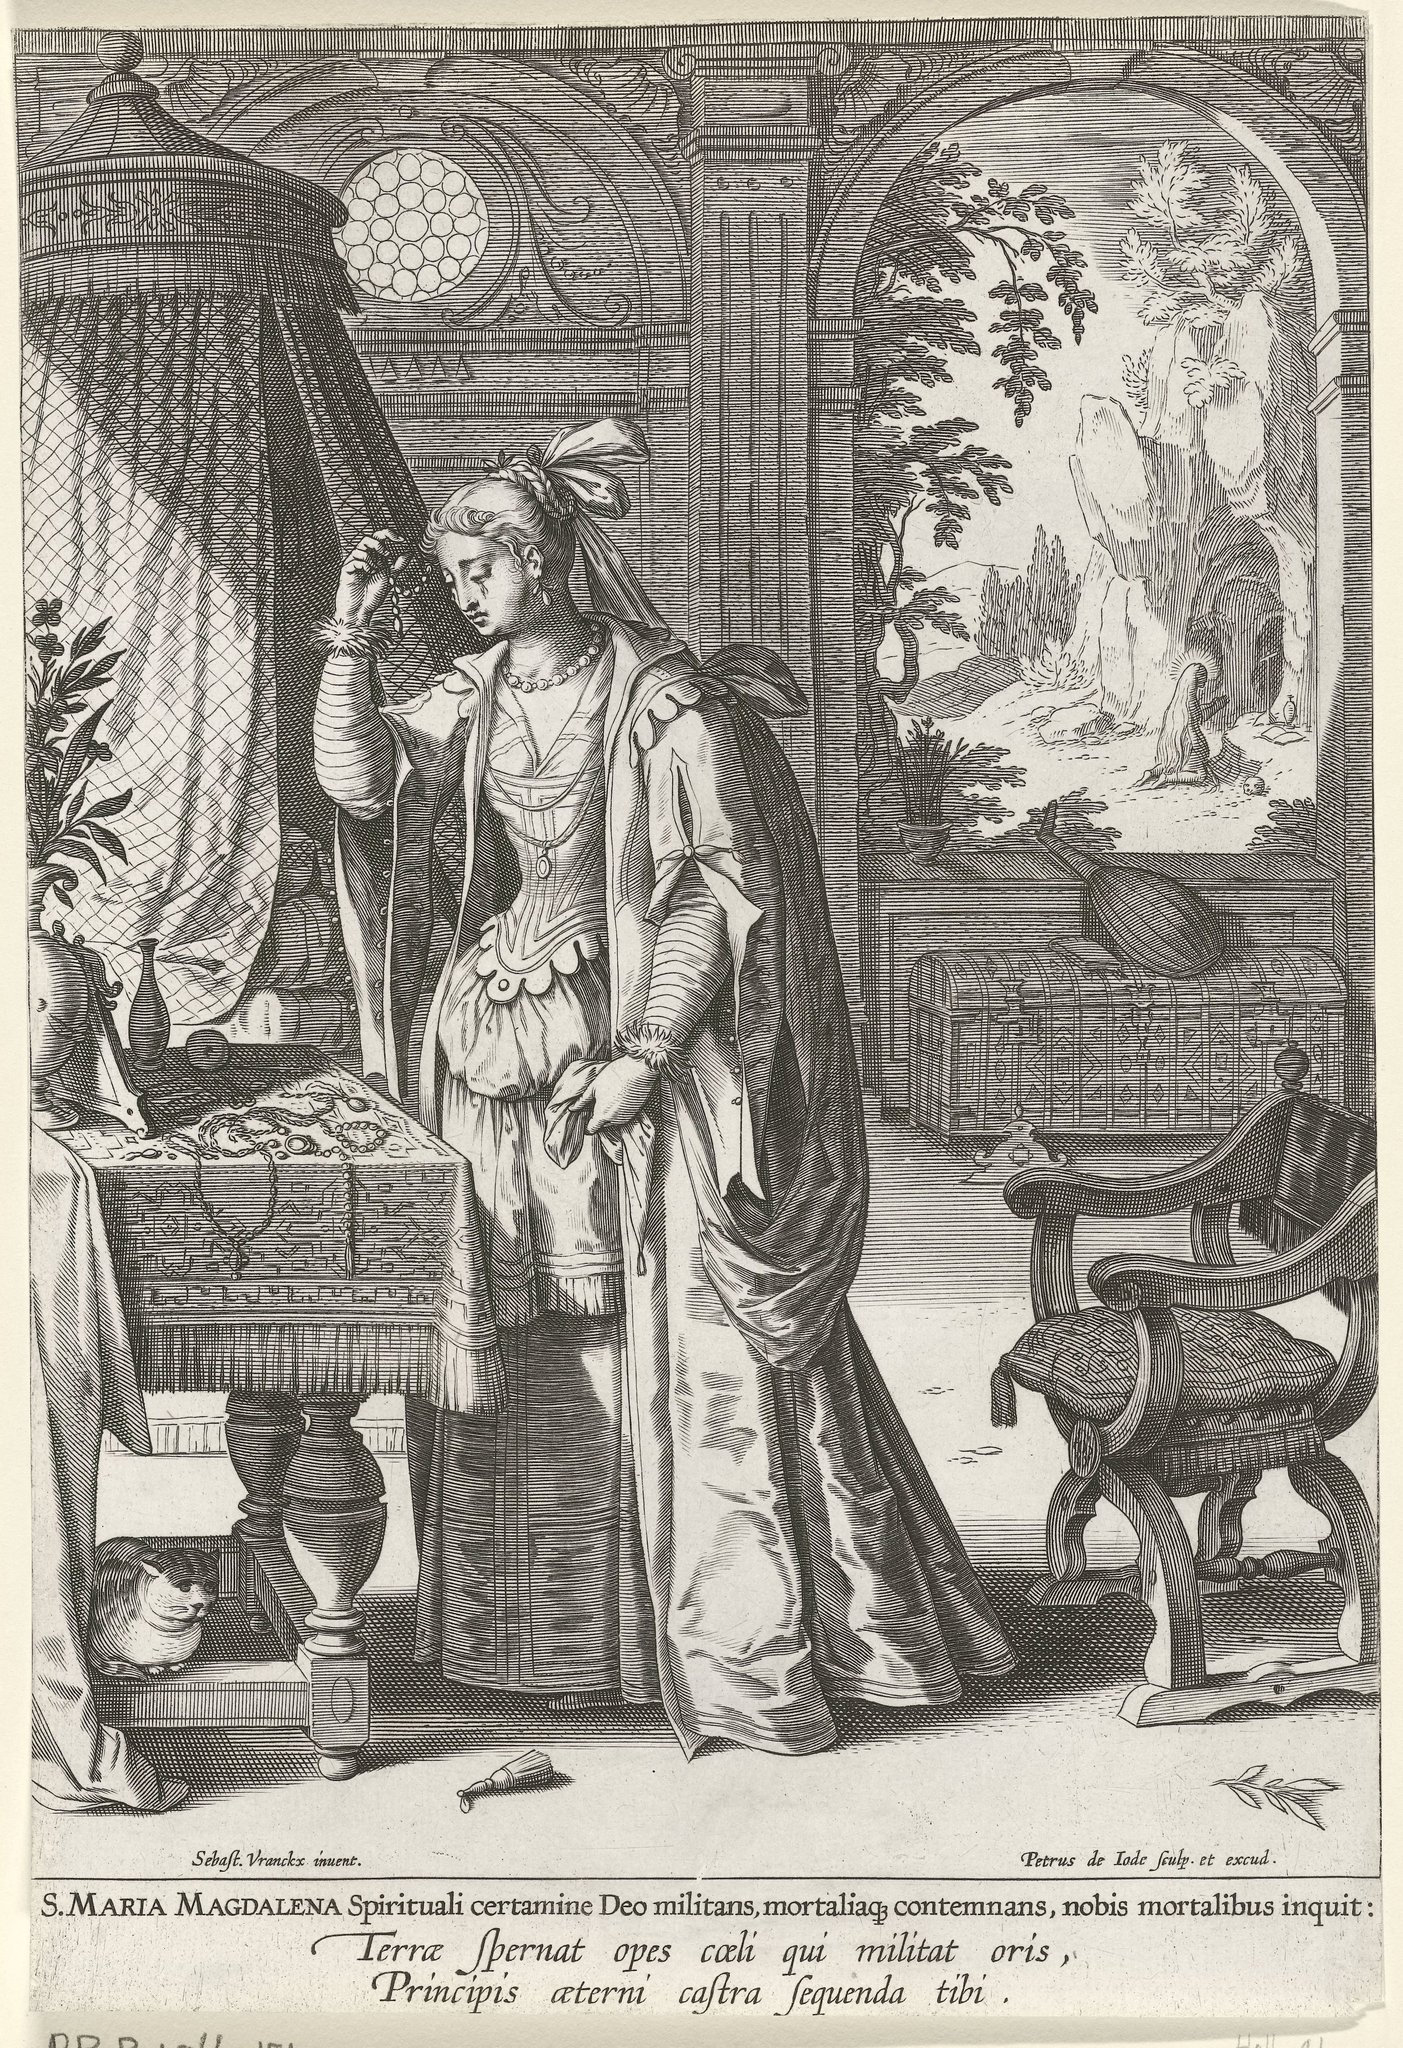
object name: print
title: Maria Magdalena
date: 1590-1632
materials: paper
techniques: engraving, etching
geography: antwerp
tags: the penitent harlot mary magdalene; possible attributes: book (or scroll), crown, crown of thorns, crucifix, jar of ointment, mirror, musical instrument, palm-branch, rosary, scourge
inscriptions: collector's mark: Lugt 2228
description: Interieur met Maria Magdalena, bij een toilettafel. Huilend doet ze haar sieraden af, waarmee ze haar luxueuze (zondige) leven vaarwel zegt. Rechtsachter de boetvaardige Maria Magdalena, geknield voor een crucifix bij een grot. In de marge een drieregelig onderschrift in het Latijn.